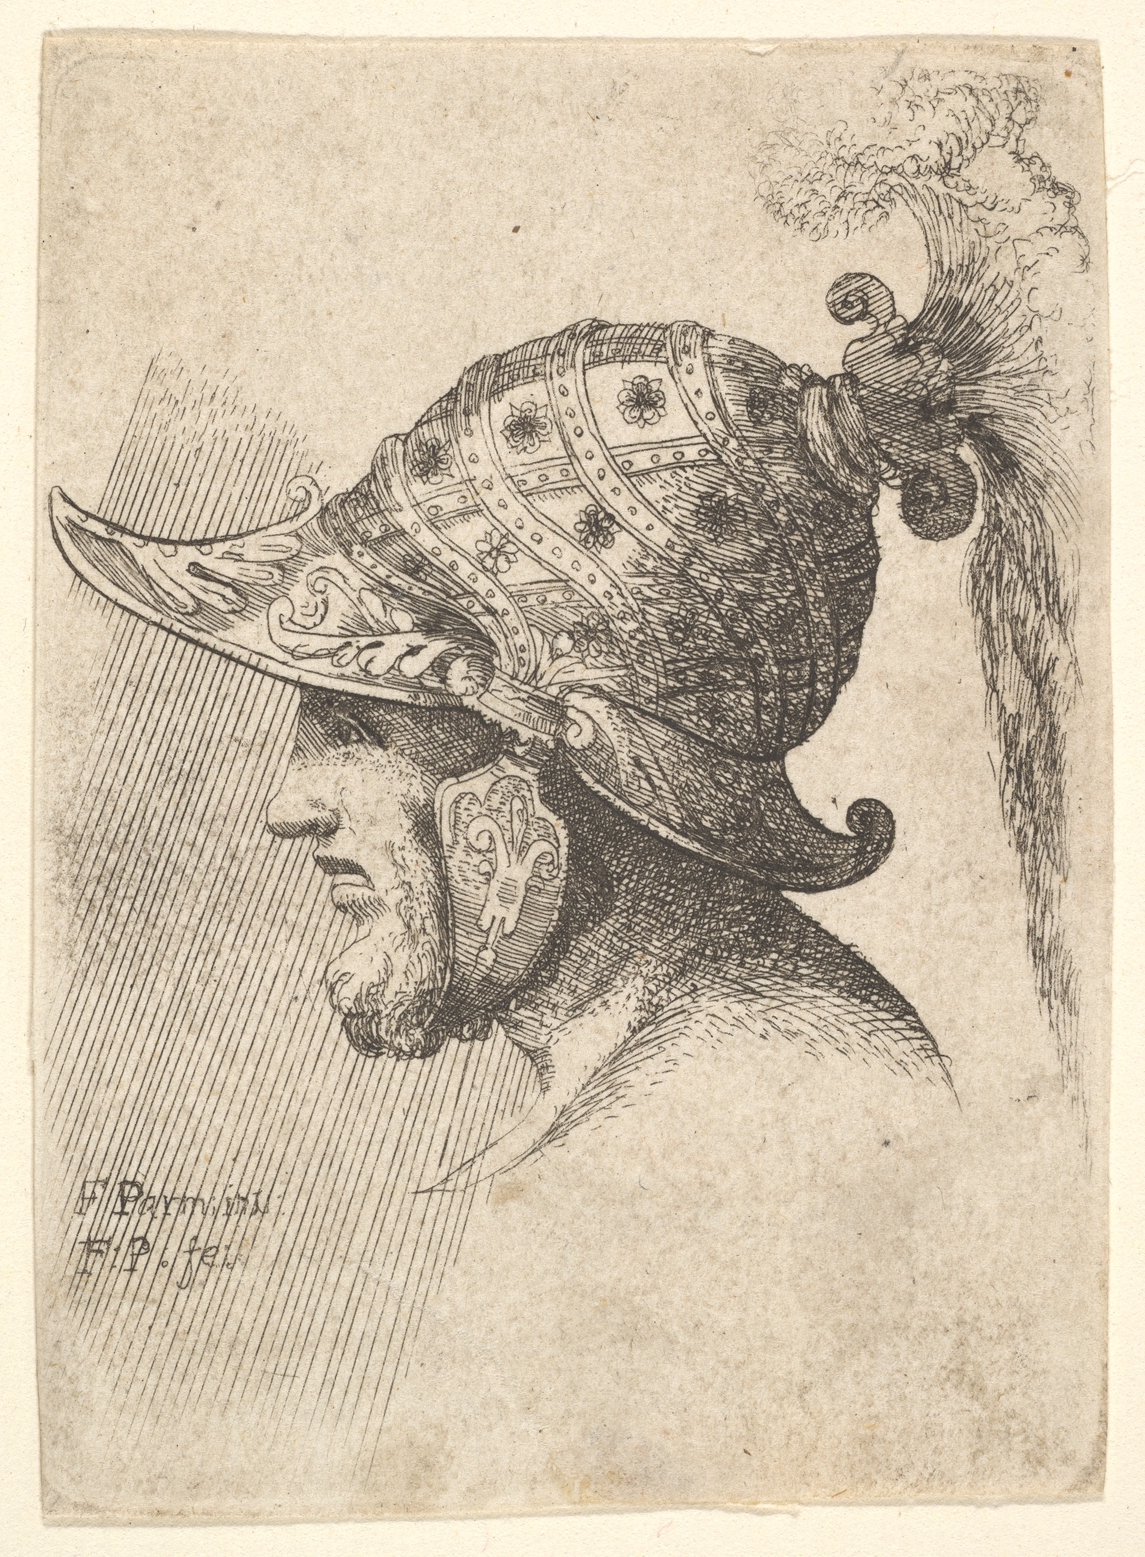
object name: print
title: Helmeted head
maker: francis place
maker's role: etcher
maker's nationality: british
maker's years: 1647-1728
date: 1662-1678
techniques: etching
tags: helmets,men